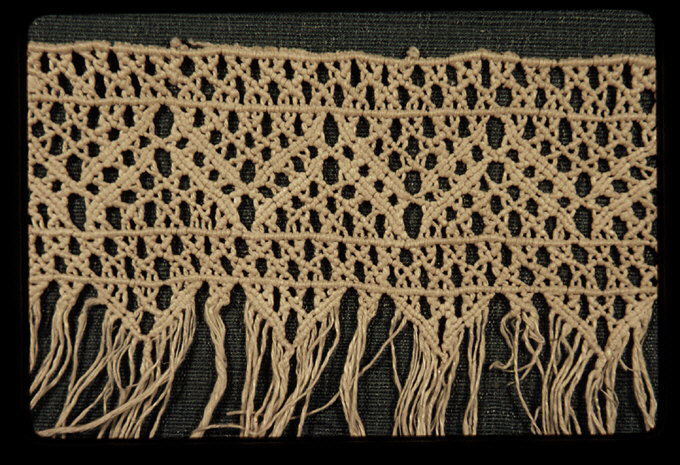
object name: edging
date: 1601-1700